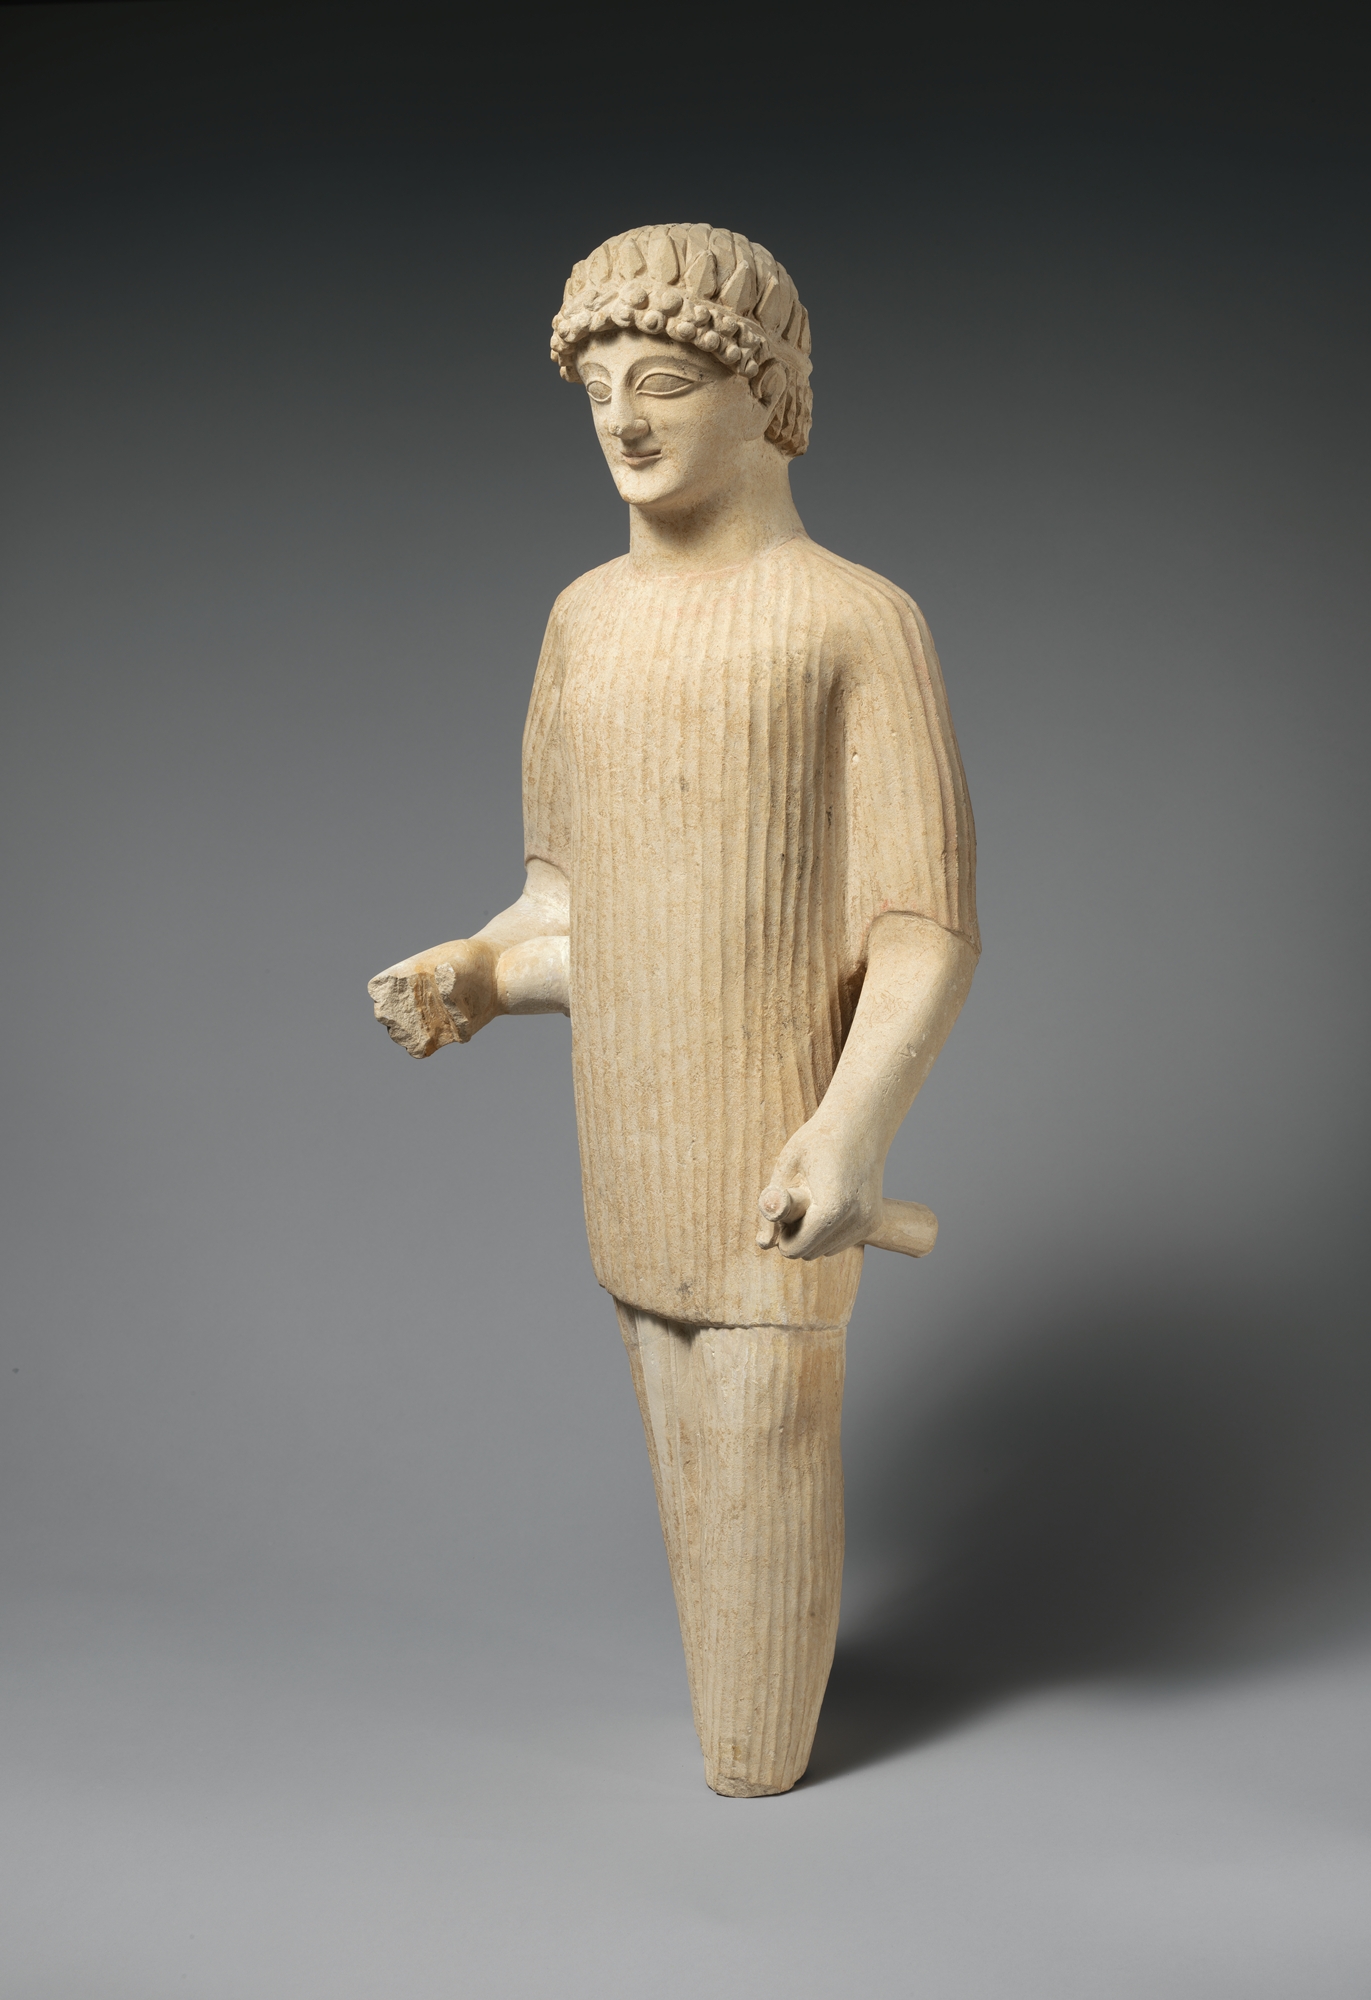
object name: statue of a male votary wearing a wreath and long tunic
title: Limestone statue of a male votary wearing a wreath and long tunic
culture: cypriot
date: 425-400 BCE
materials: limestone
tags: men